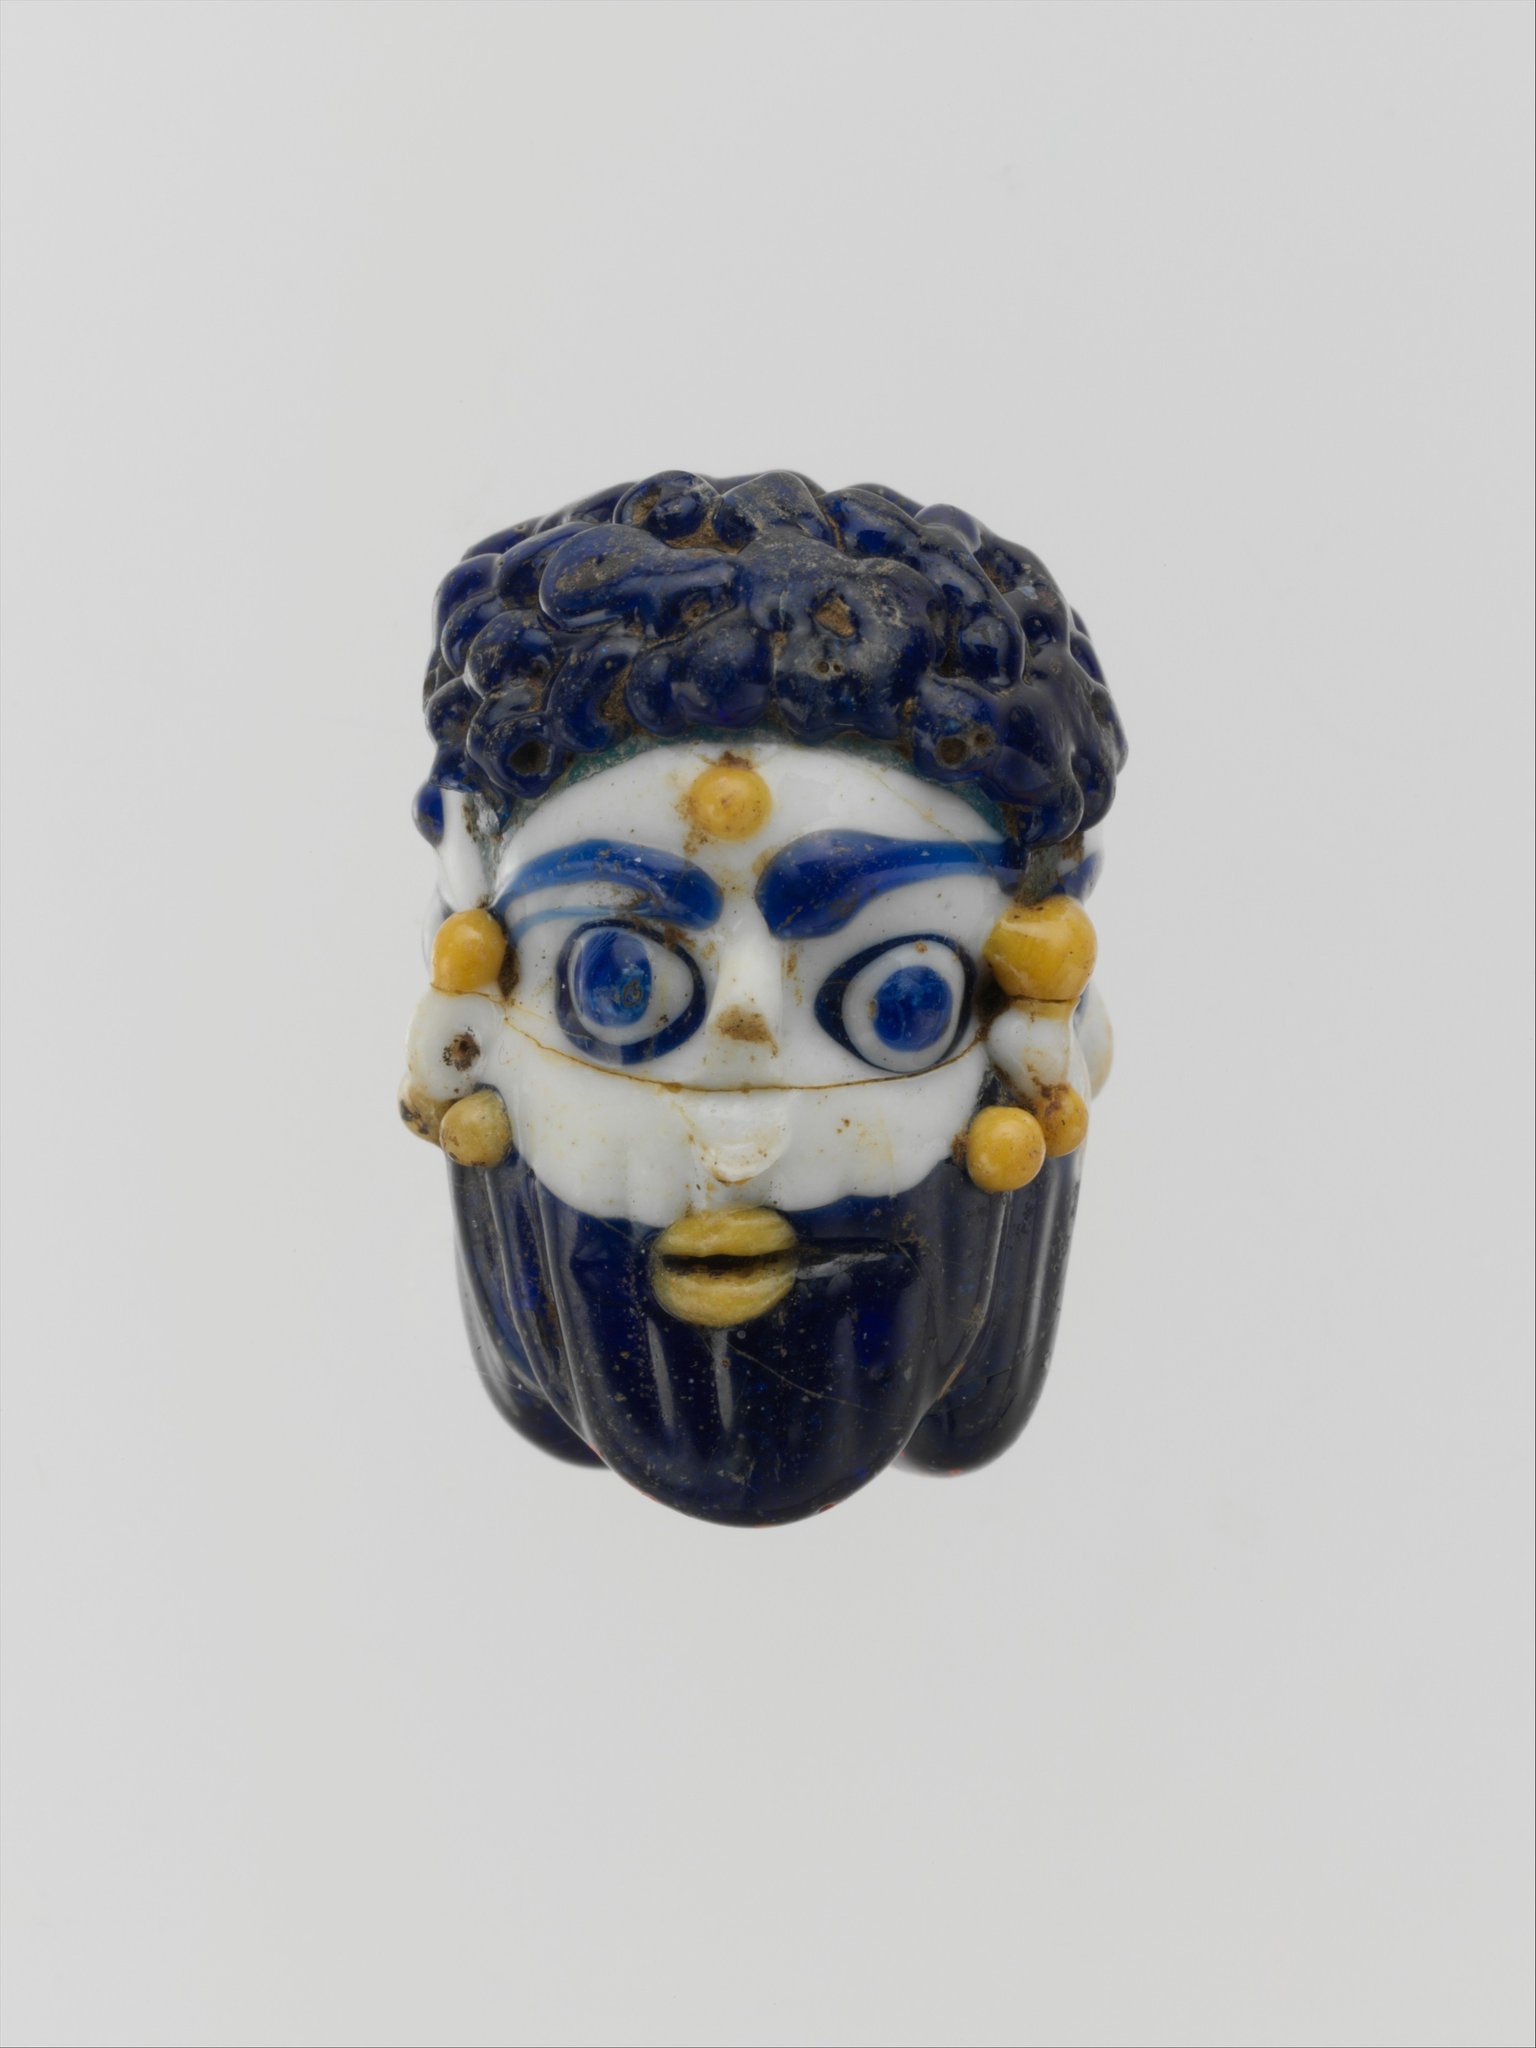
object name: face bead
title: Glass face bead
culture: carthaginian or phoenician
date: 367-201 BCE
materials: glass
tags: faces